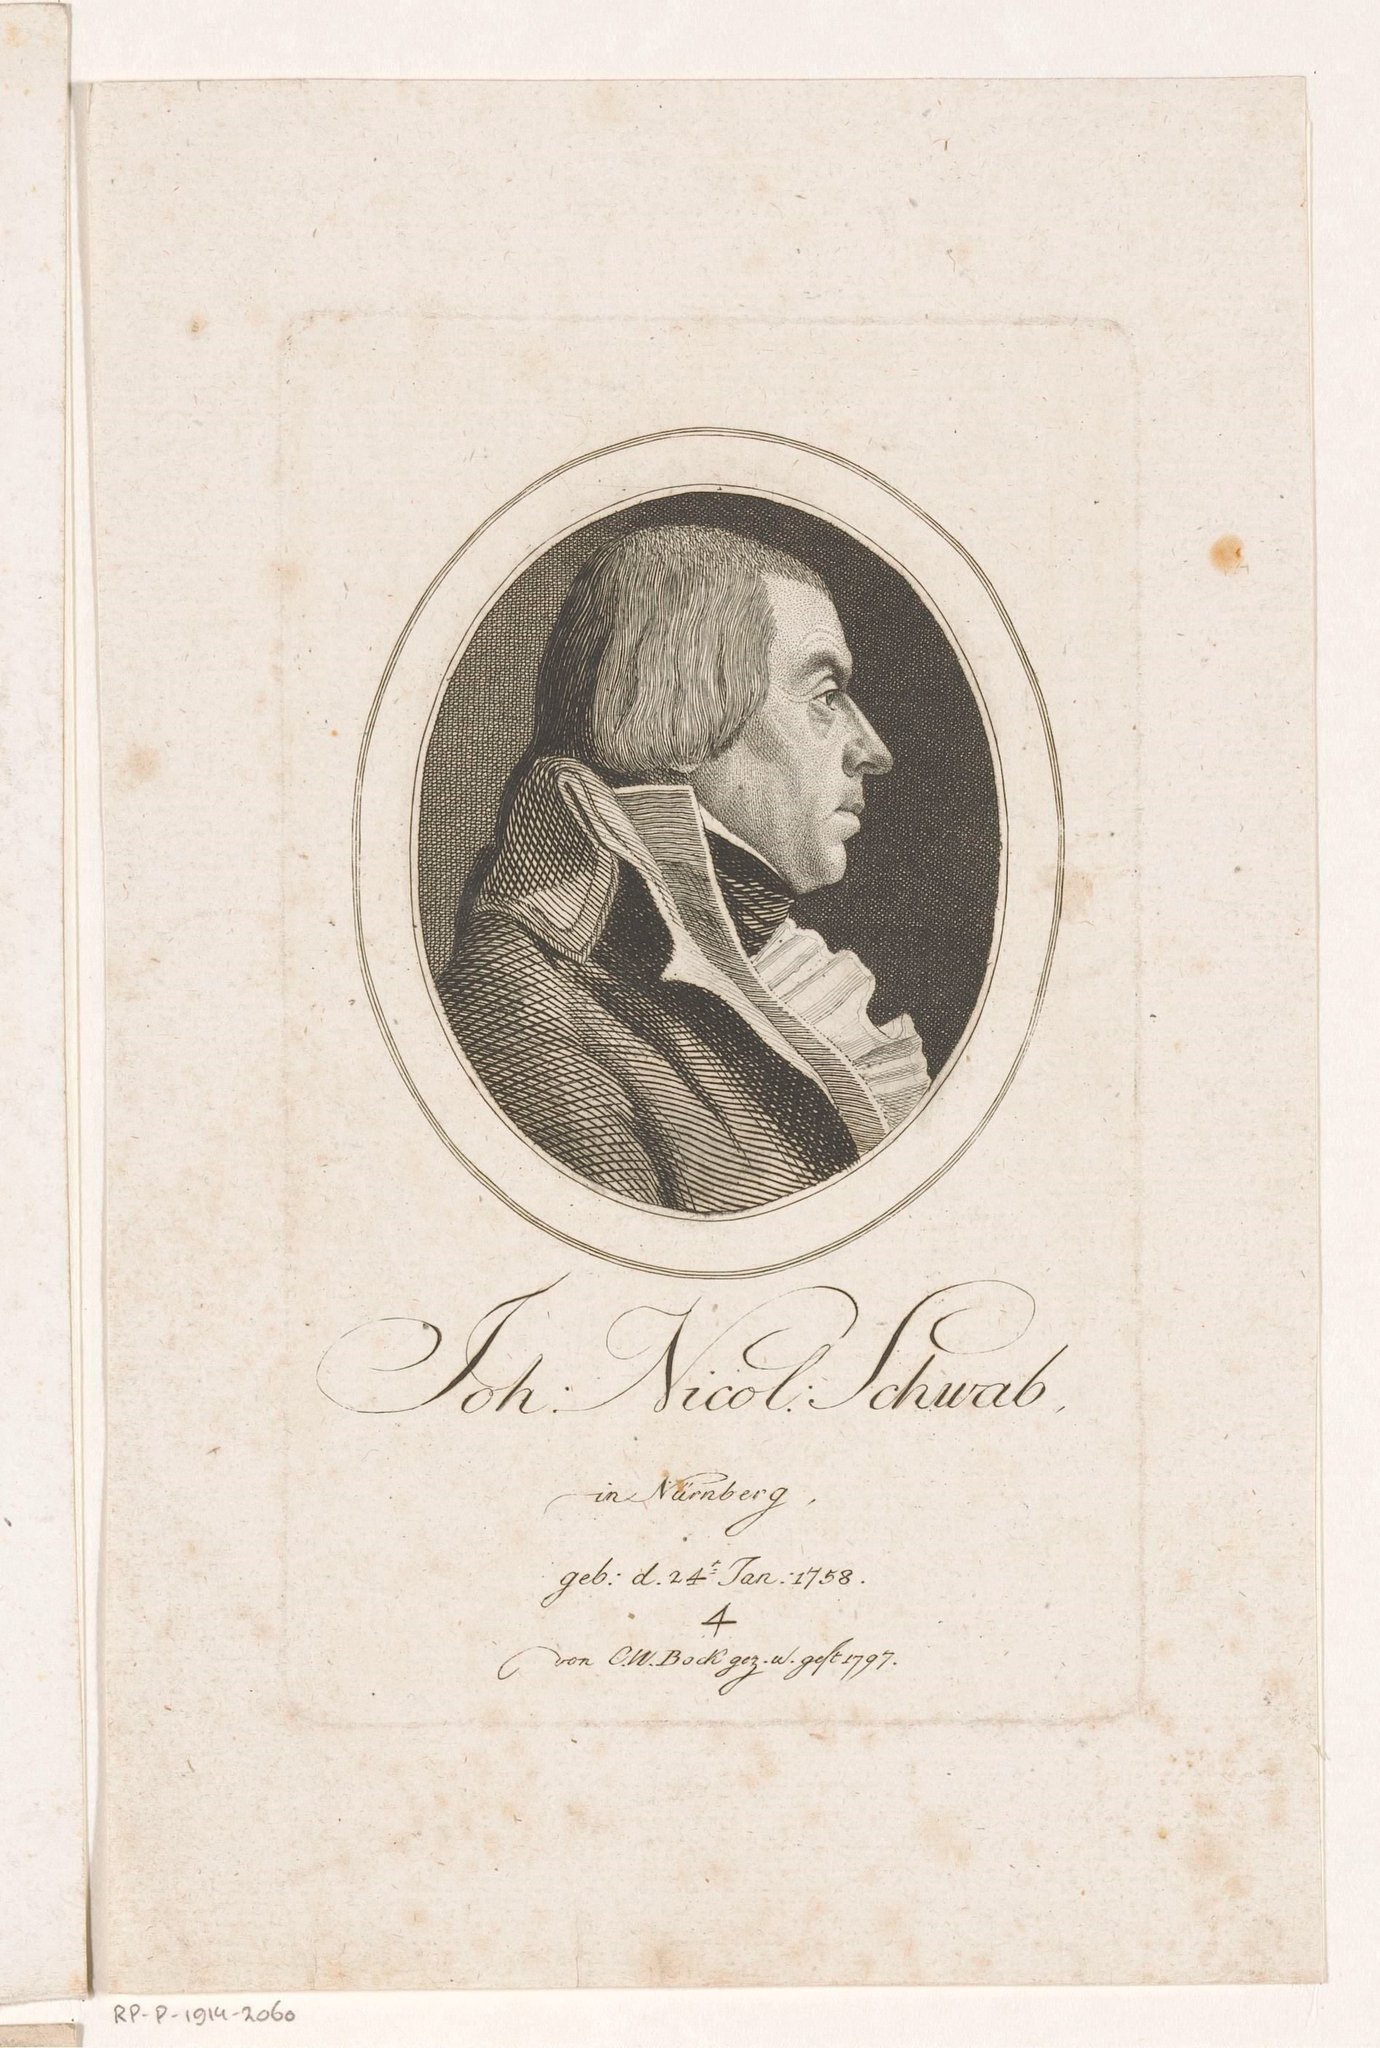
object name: print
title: Portret van Johann Nicolaus Schwab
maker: christoph wilhelm bock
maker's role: print maker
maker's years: 1755-1836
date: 1797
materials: paper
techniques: engraving, etching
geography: nuremberg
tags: historical persons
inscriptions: collector's mark: Lugt 2228